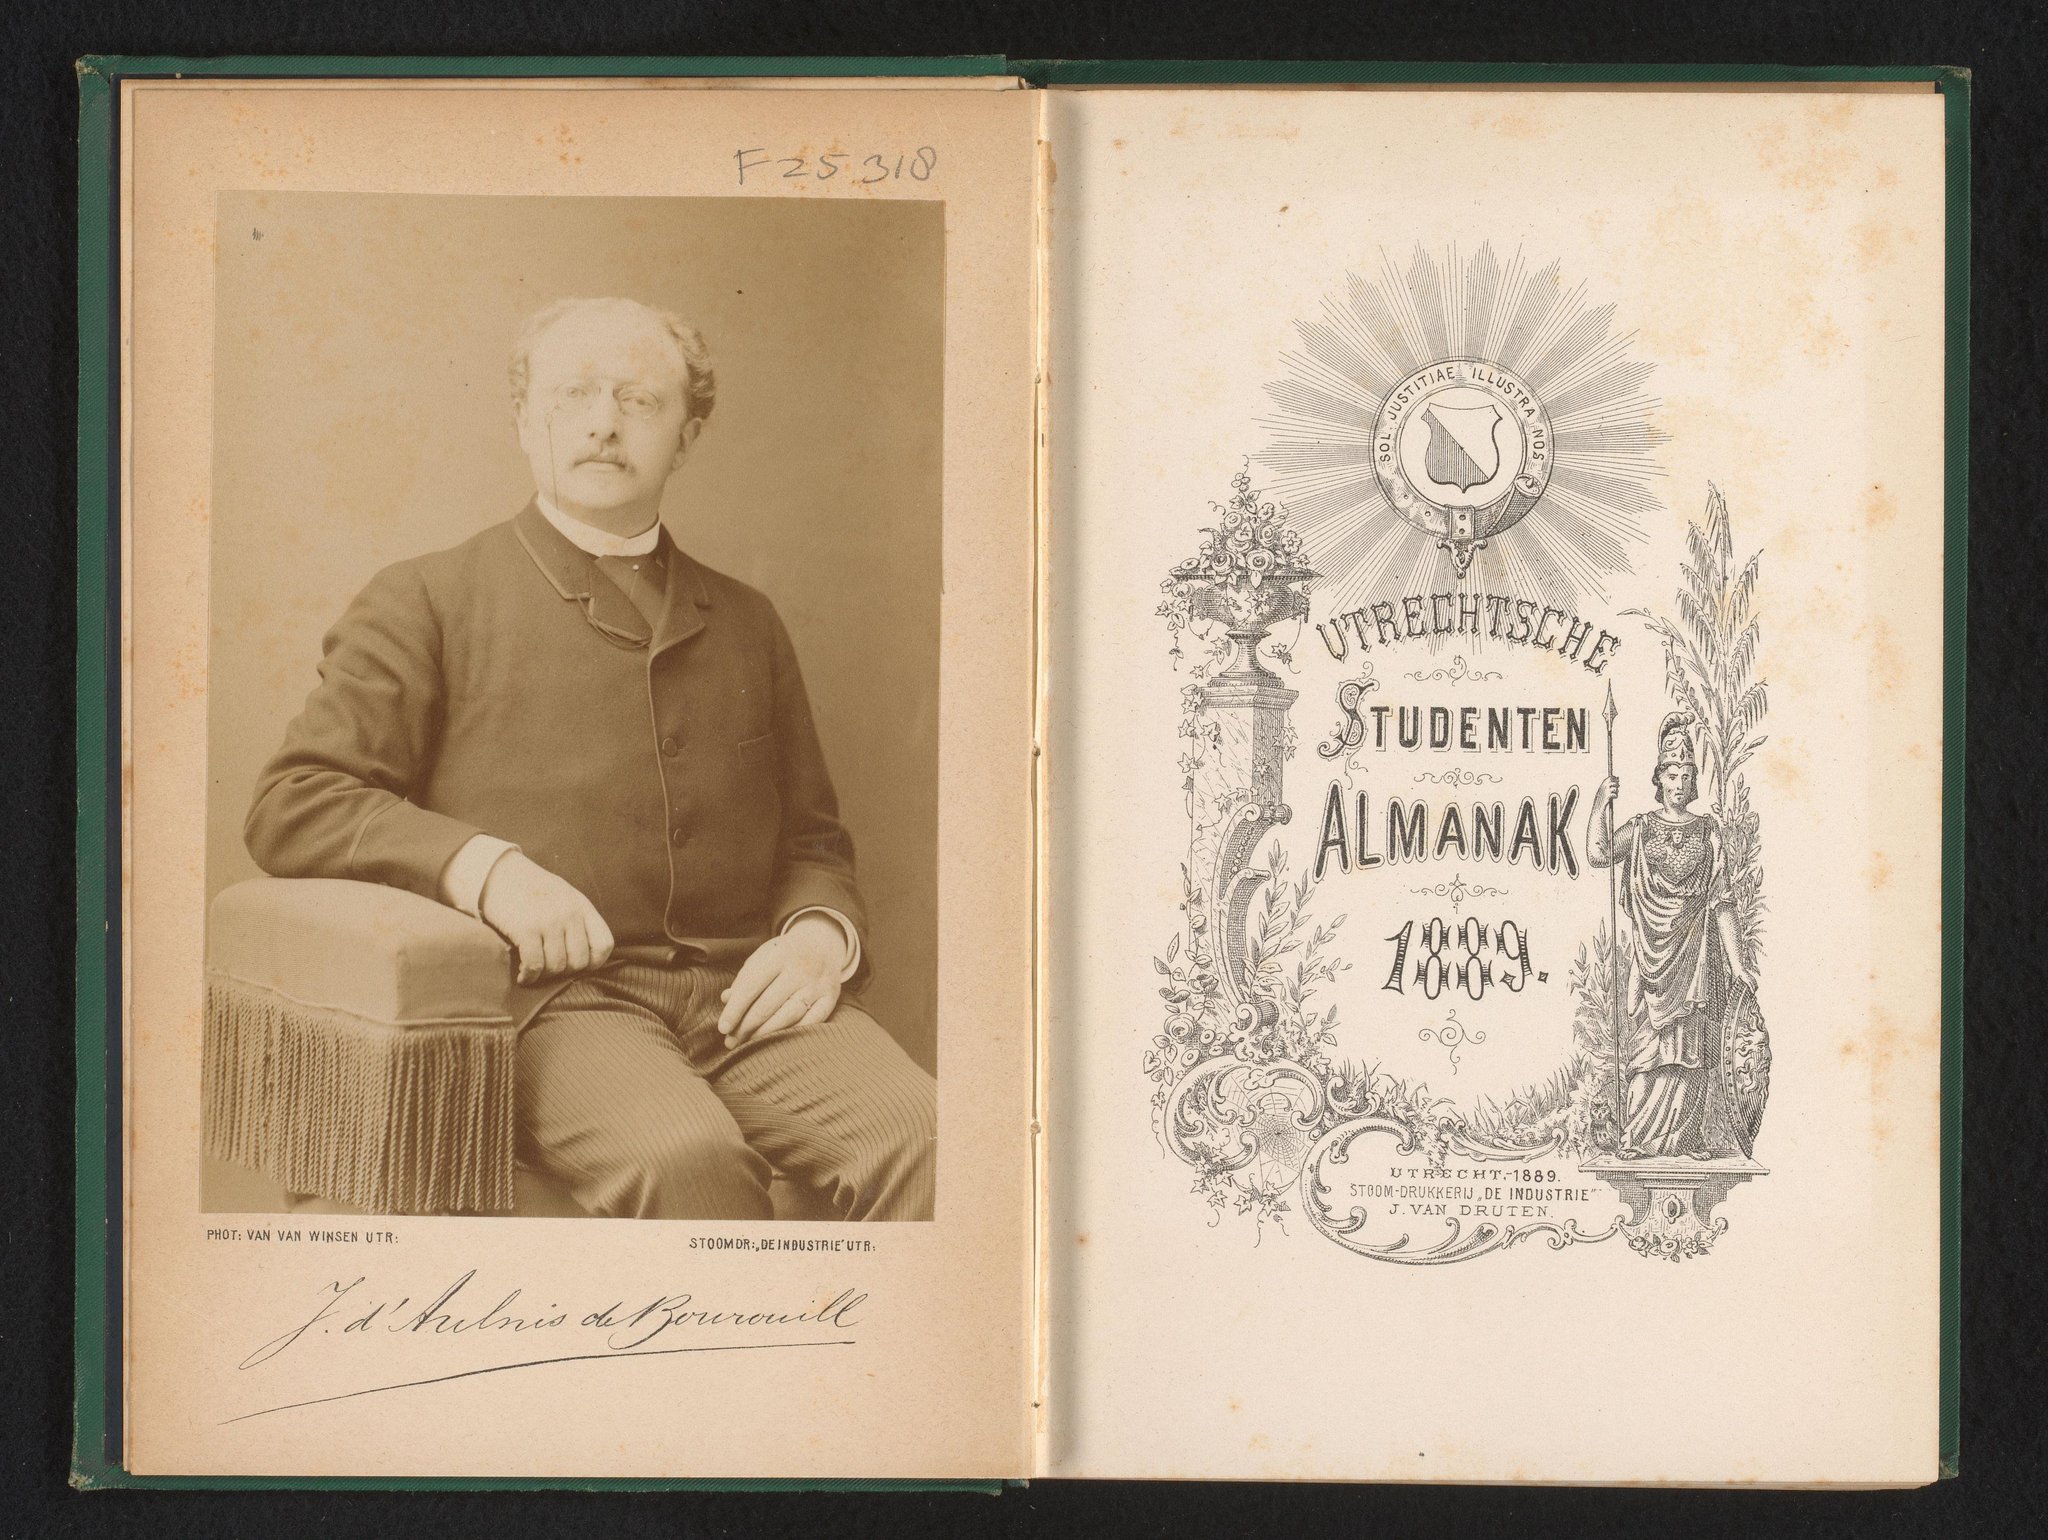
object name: photograph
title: Portret van Johan baron d'Aulnis de Bourouill, hoogleraar rechtsgeleerdheid en rector magnificus van de Universiteit Utrecht 1888-1889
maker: jean jacques antoine van winsen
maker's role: fotograaf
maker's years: 1851-1927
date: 1888-1889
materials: paper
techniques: albumen print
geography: utrecht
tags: groningen (province), historical persons, professor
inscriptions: signature: ‘J. d'Aulnis de Bourouill’